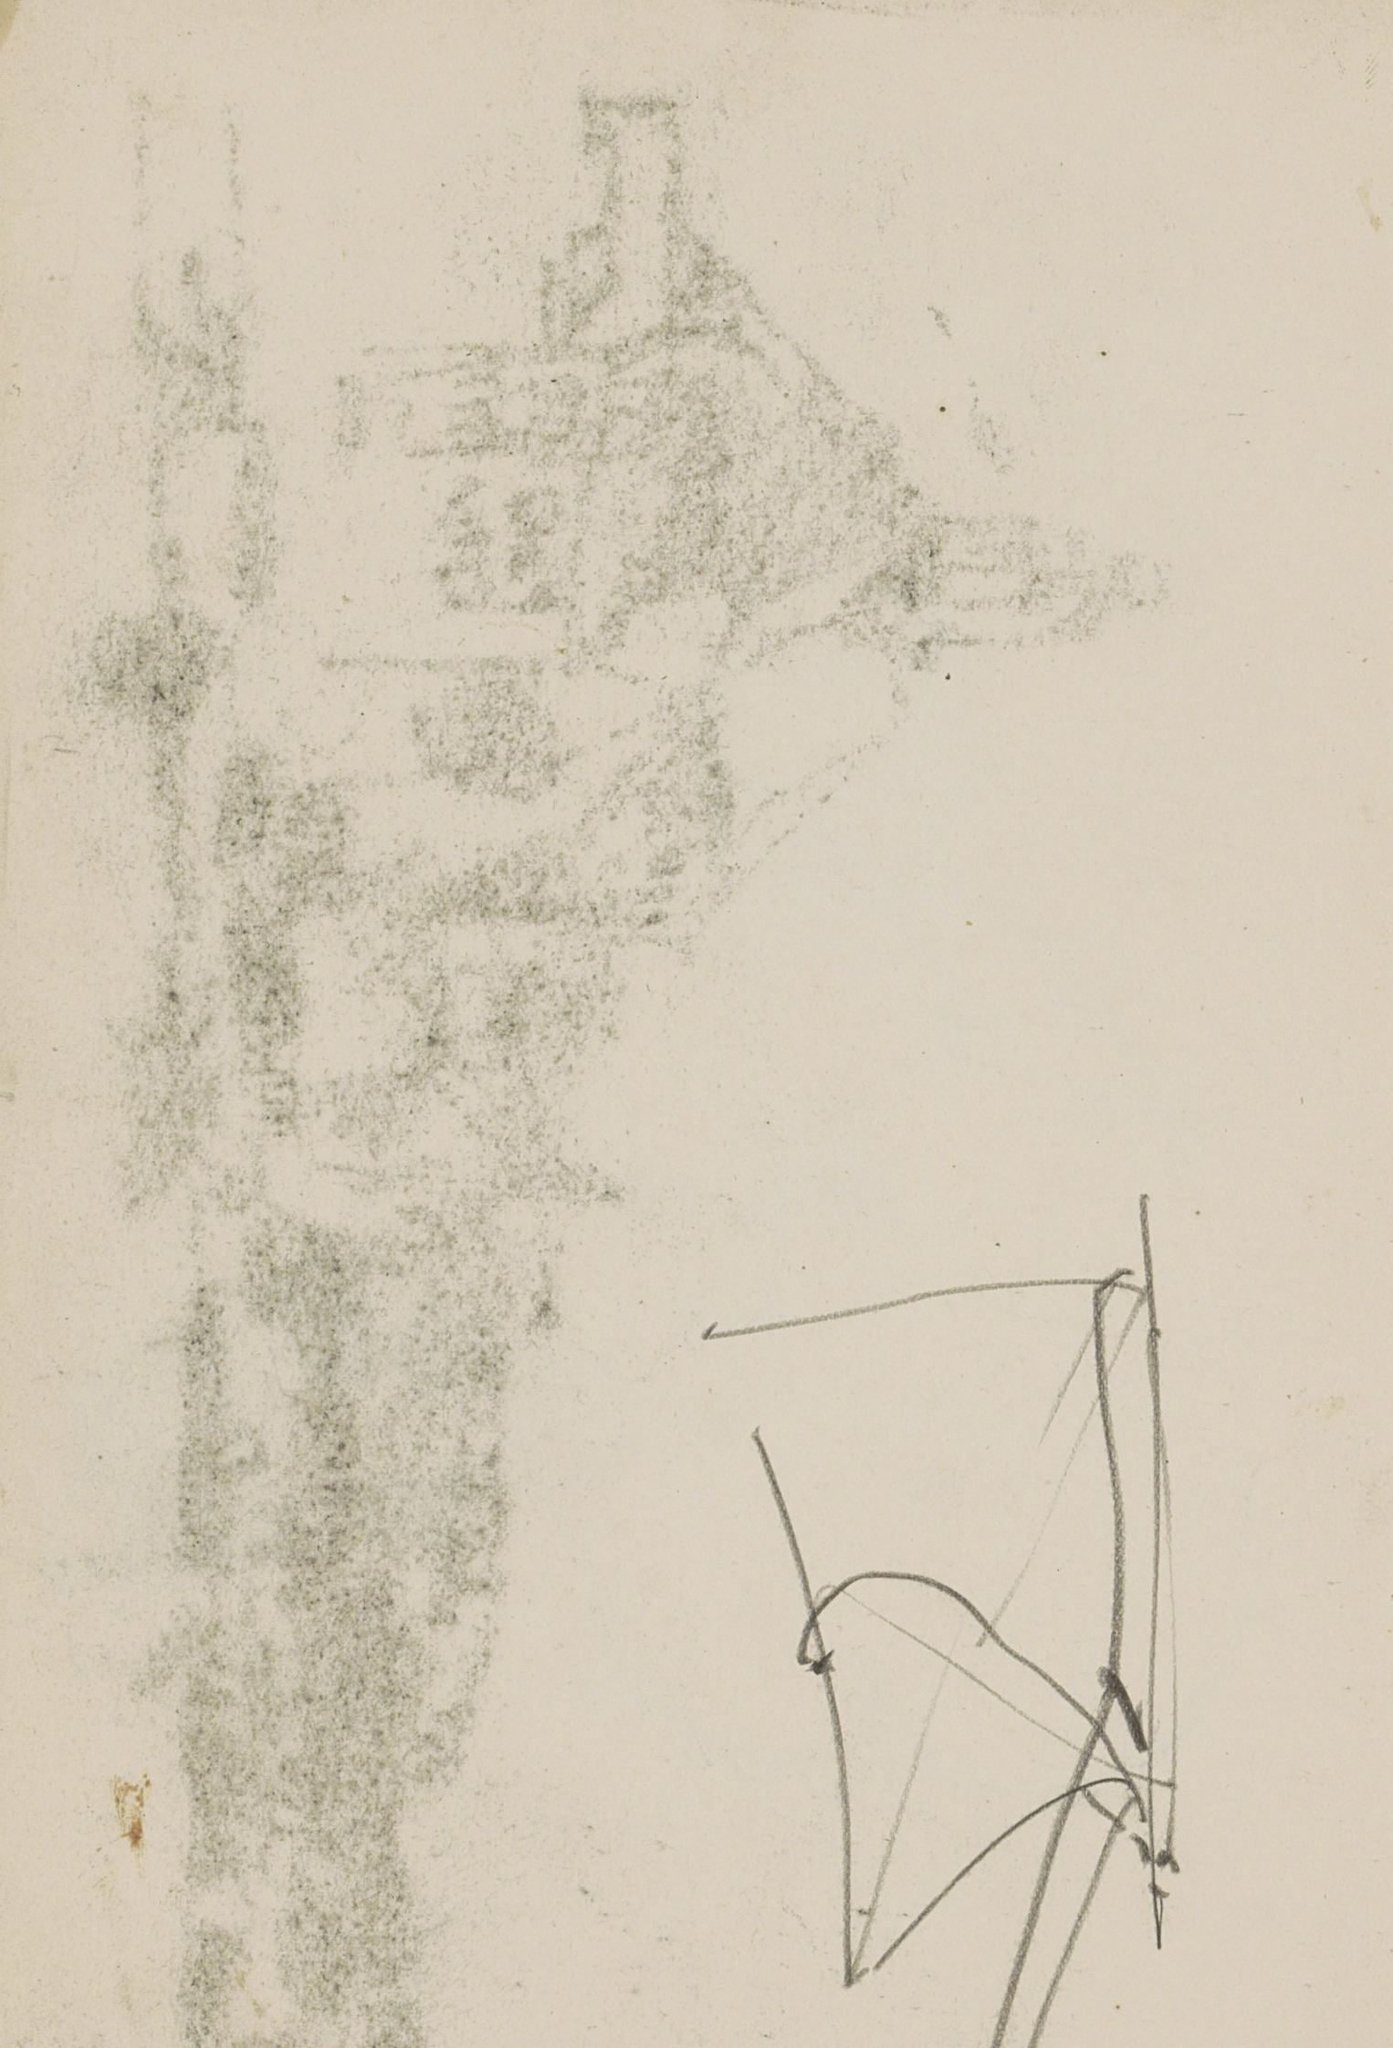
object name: sketchbook leaf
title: Vlag of zeil aan een mast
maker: cornelis vreedenburgh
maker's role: draughtsman, print maker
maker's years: 1880-1946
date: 1890-1946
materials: chalk, paper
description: Blad 32 verso uit een schetsboek met 47 bladen.